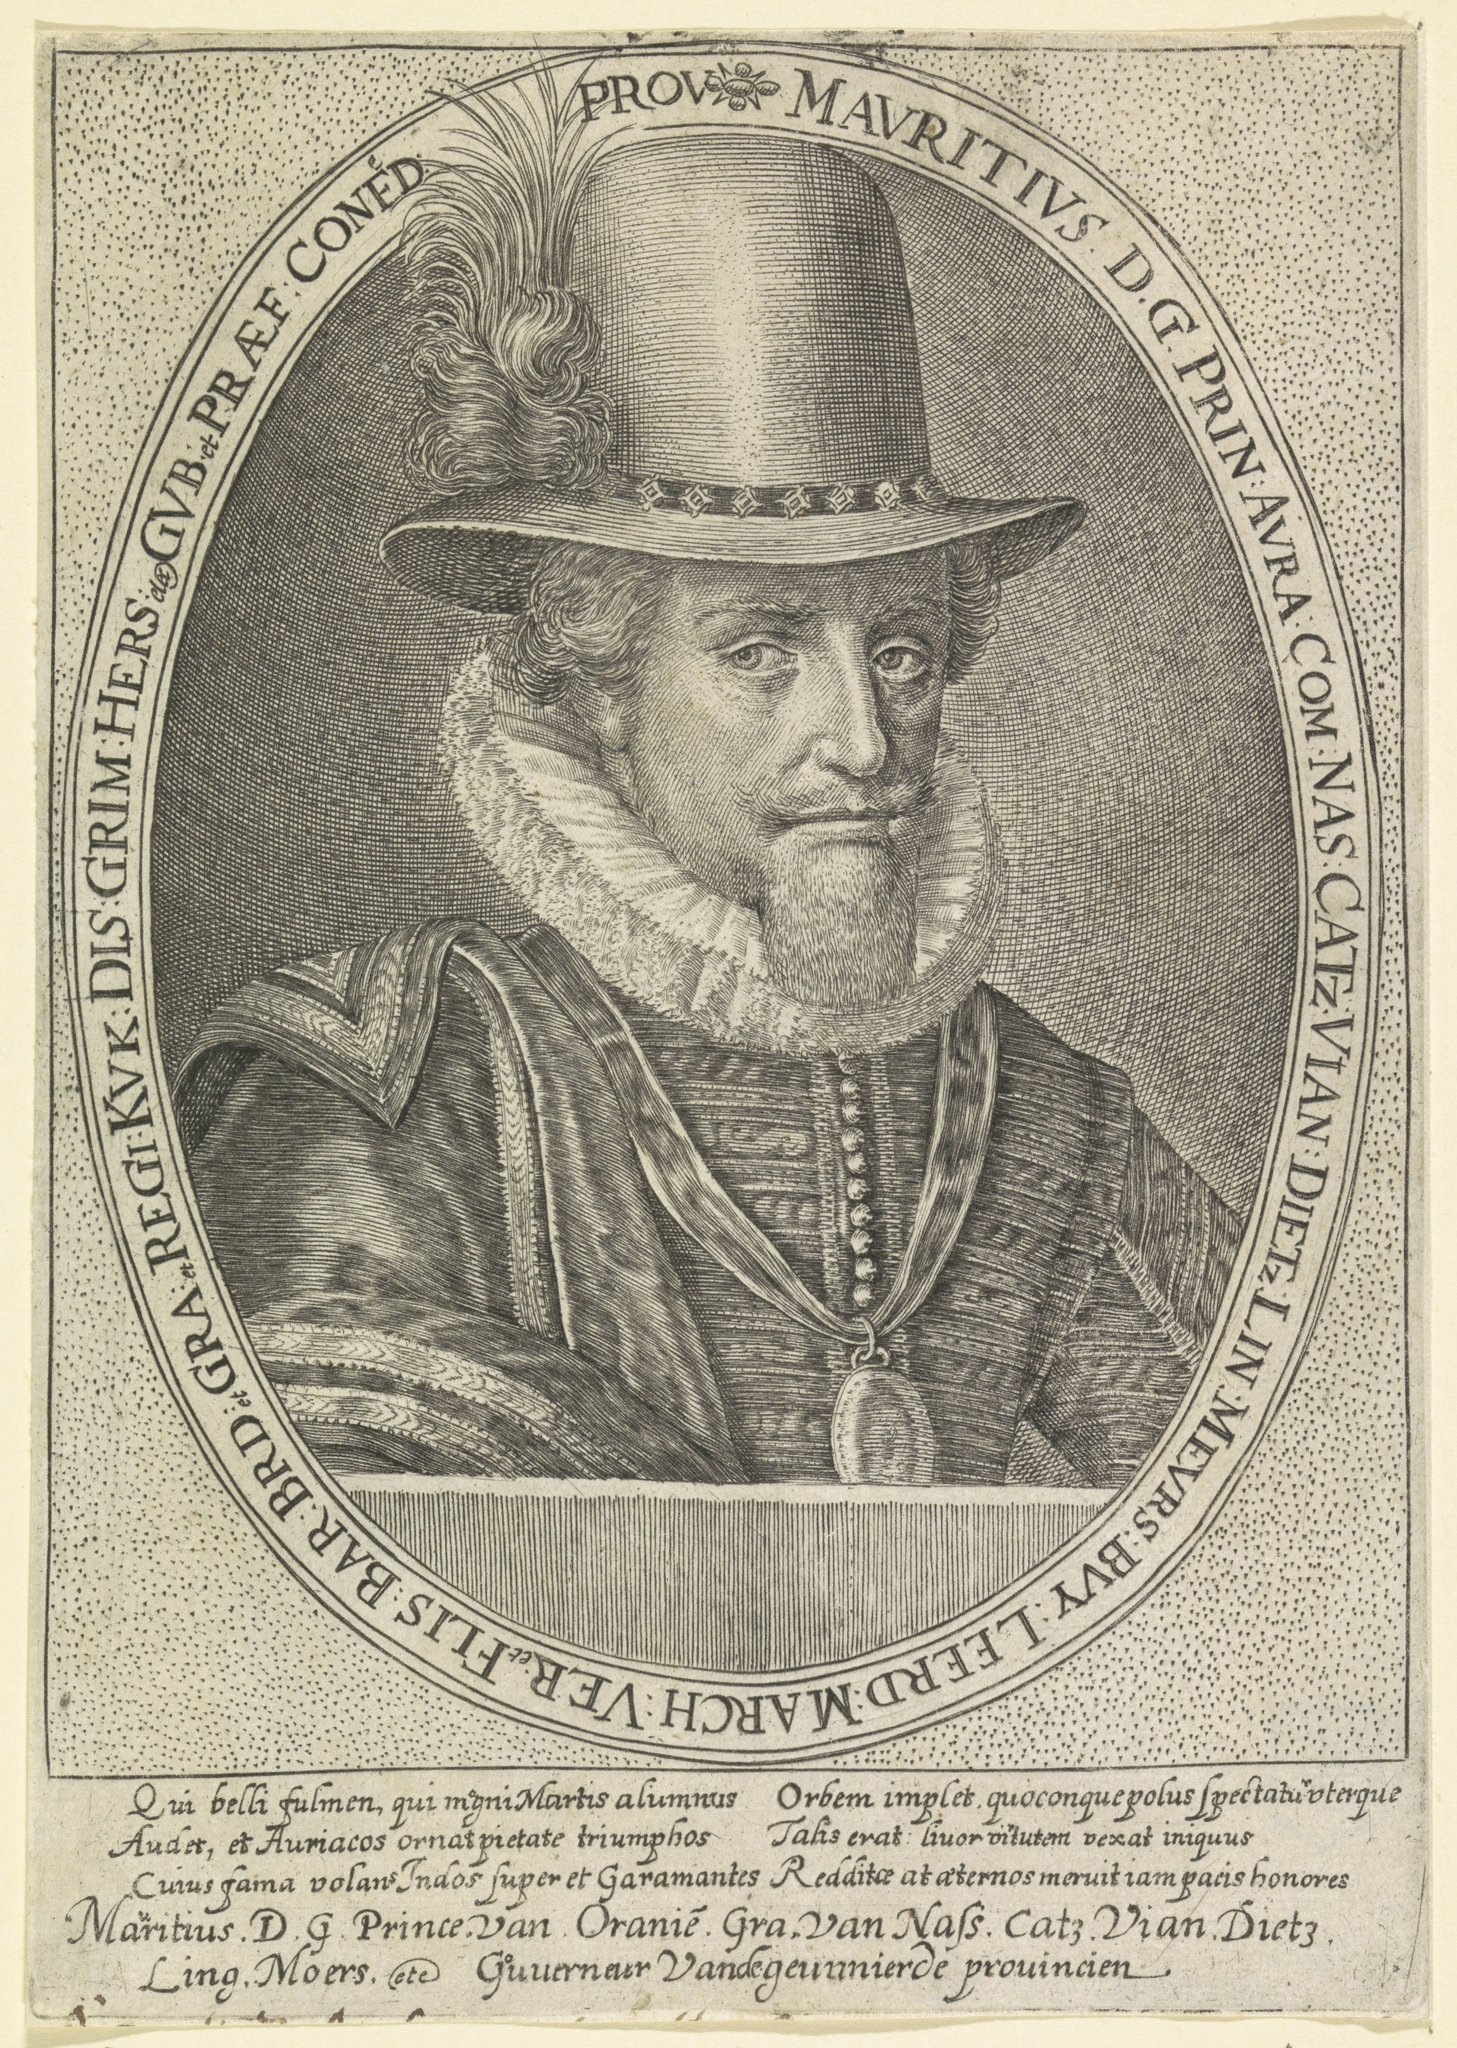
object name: print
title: Portret van Maurits, prins van Oranje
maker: crispijn van de passe (i)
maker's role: draughtsman, print maker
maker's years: 1564-1637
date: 1612-1637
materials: paper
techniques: engraving, etching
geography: low countries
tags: the hague, maurice (prince of orange), knighthood order (garter) - insignia of a knighthood order, e.g.: badge, chain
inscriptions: collector's mark: Lugt 963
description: De hier vermelde titel verwijst naar de hoogst verkregen titel van de geportretteerde, niet per se naar de titel die de geportretteerde op deze voorstelling draagt.